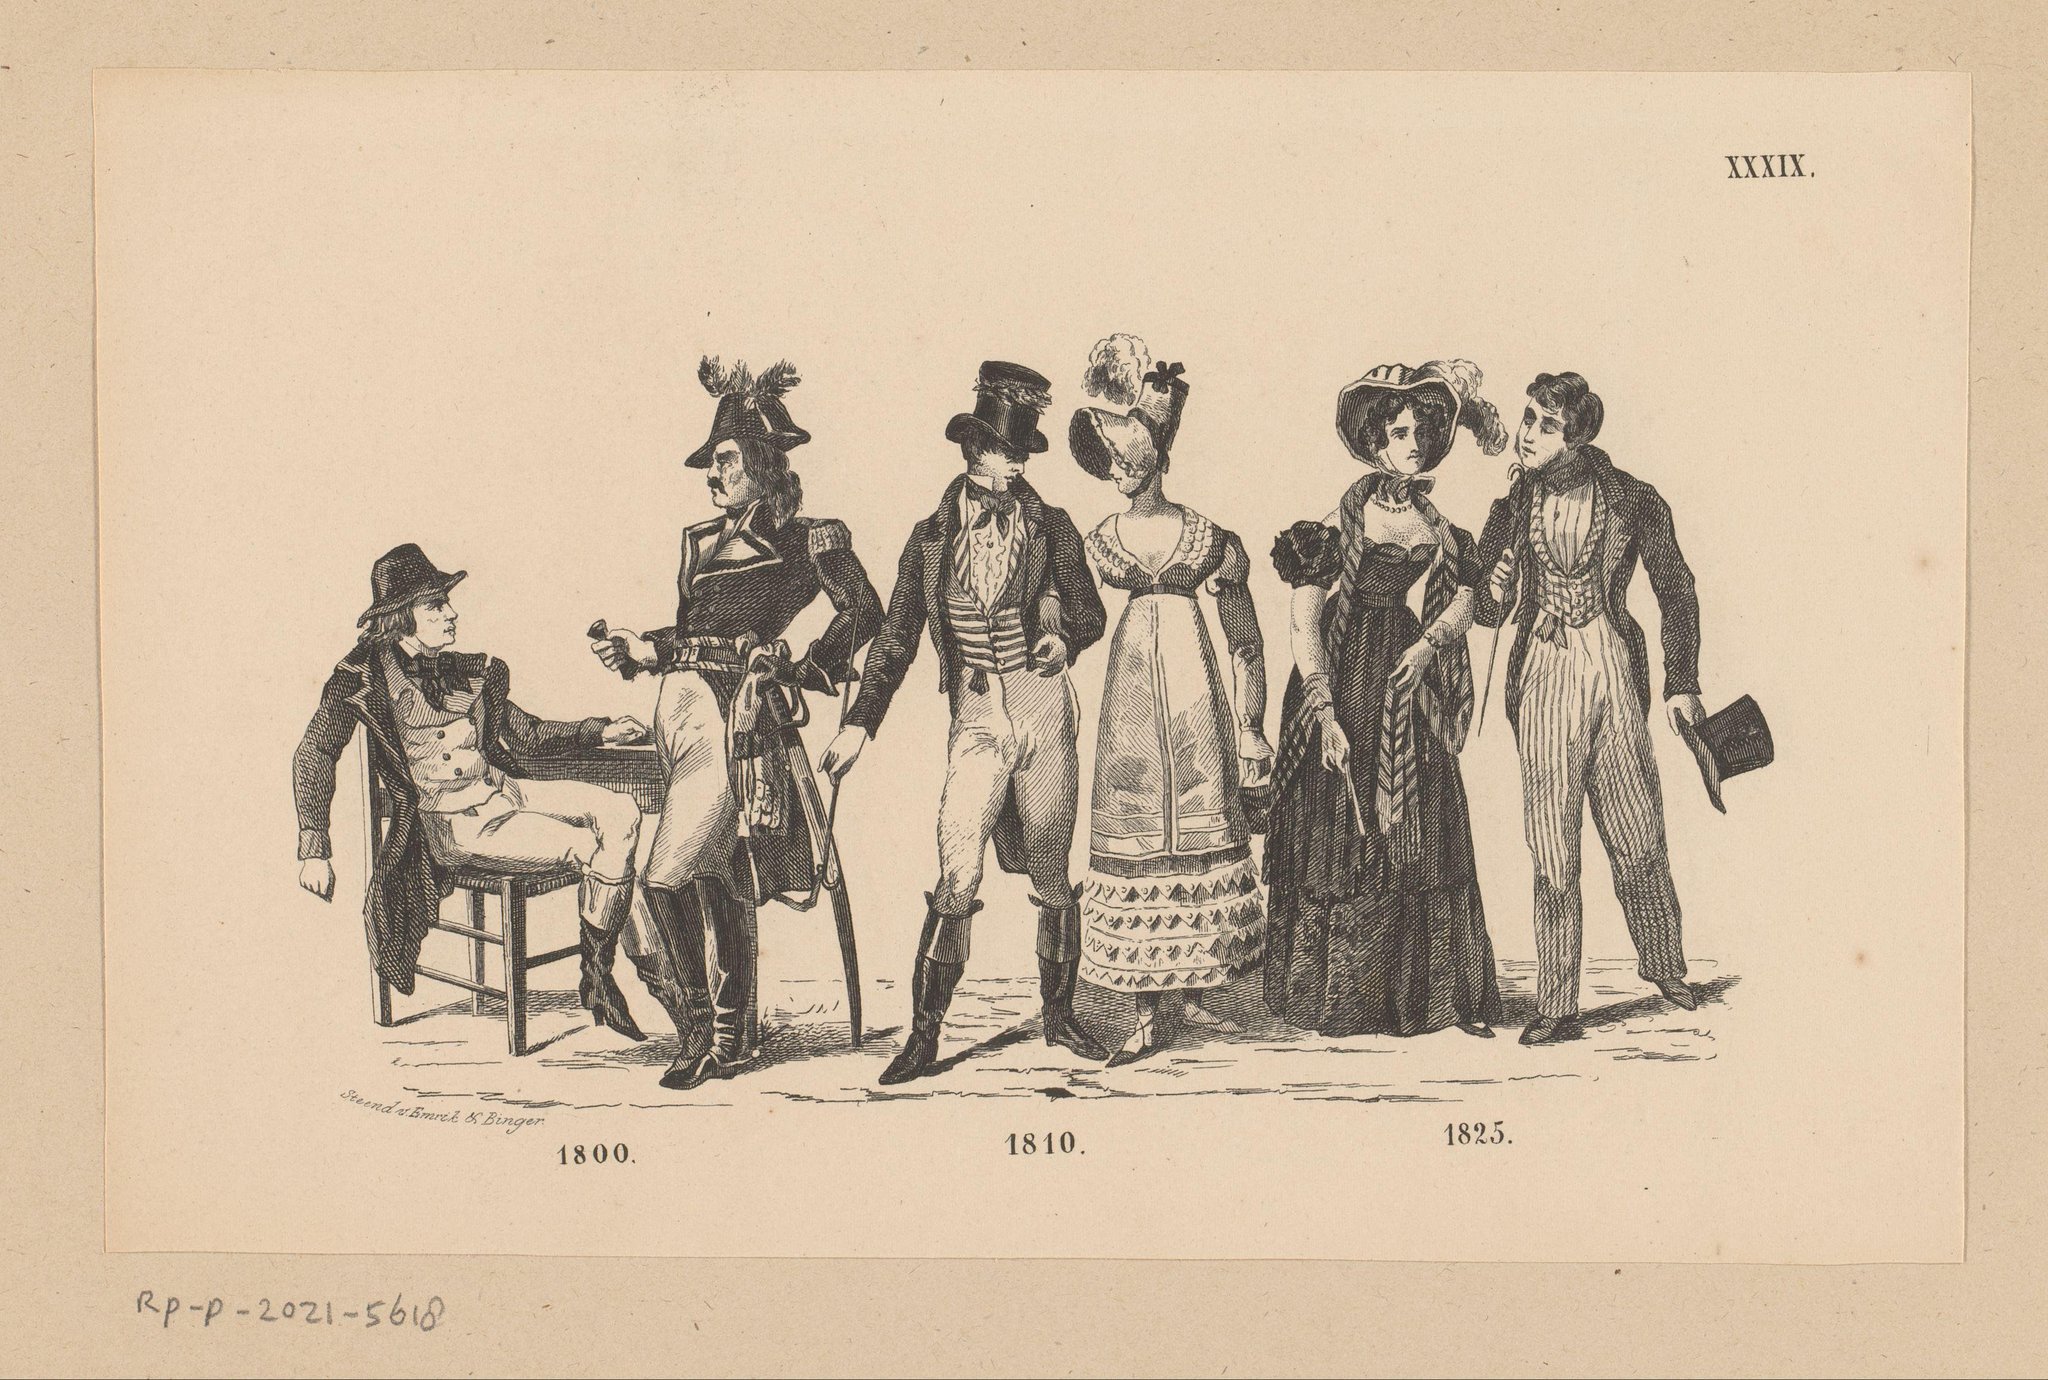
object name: print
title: Zes mannen en vrouwen in kleding uit 1800, 1810 en 1825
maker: Anonymous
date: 1857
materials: paper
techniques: lithograph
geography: haarlem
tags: the soldier; the soldier's life, clothes, costume, head-gear: top hat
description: Prent waarschijnlijk uit: Hofdijk, Willem Jacob. Schets van de geschiedenis der Nederlanden. Amsterdam: Gebroeders Binger, 1857.